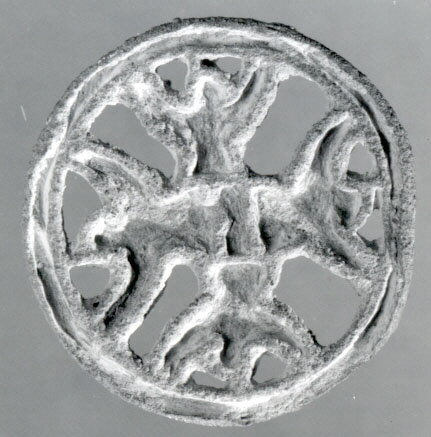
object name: stamp seal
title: Compartmented stamp seal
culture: bactria-margiana archaeological complex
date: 2333-1668 BCE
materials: copper alloy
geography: bactria-margiana